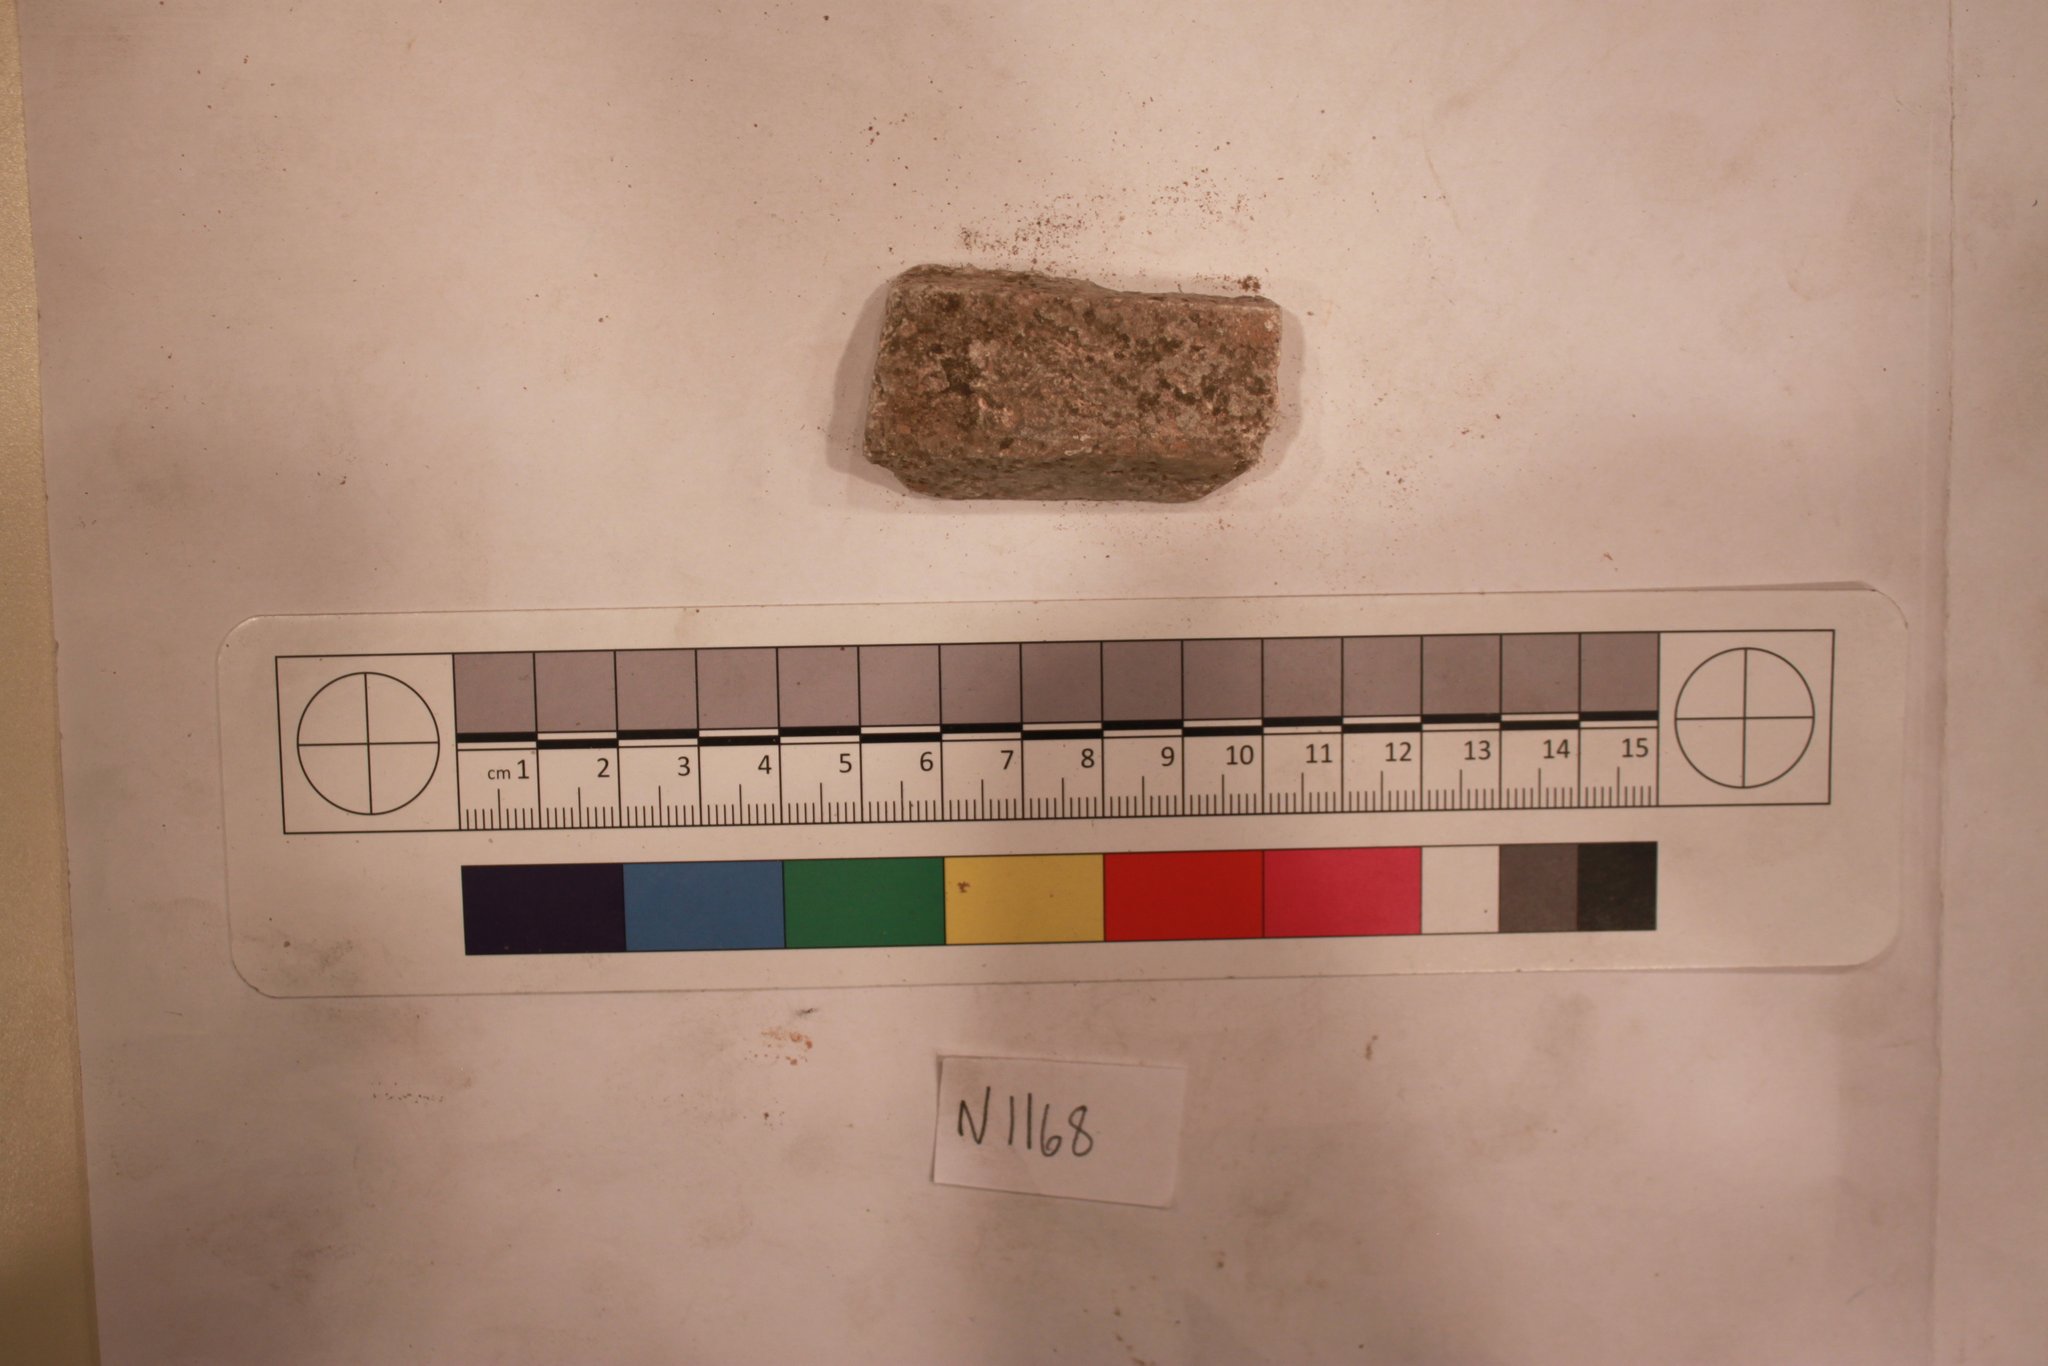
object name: fragment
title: Stucco Fragment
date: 701-1200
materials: plaster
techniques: carving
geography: iran